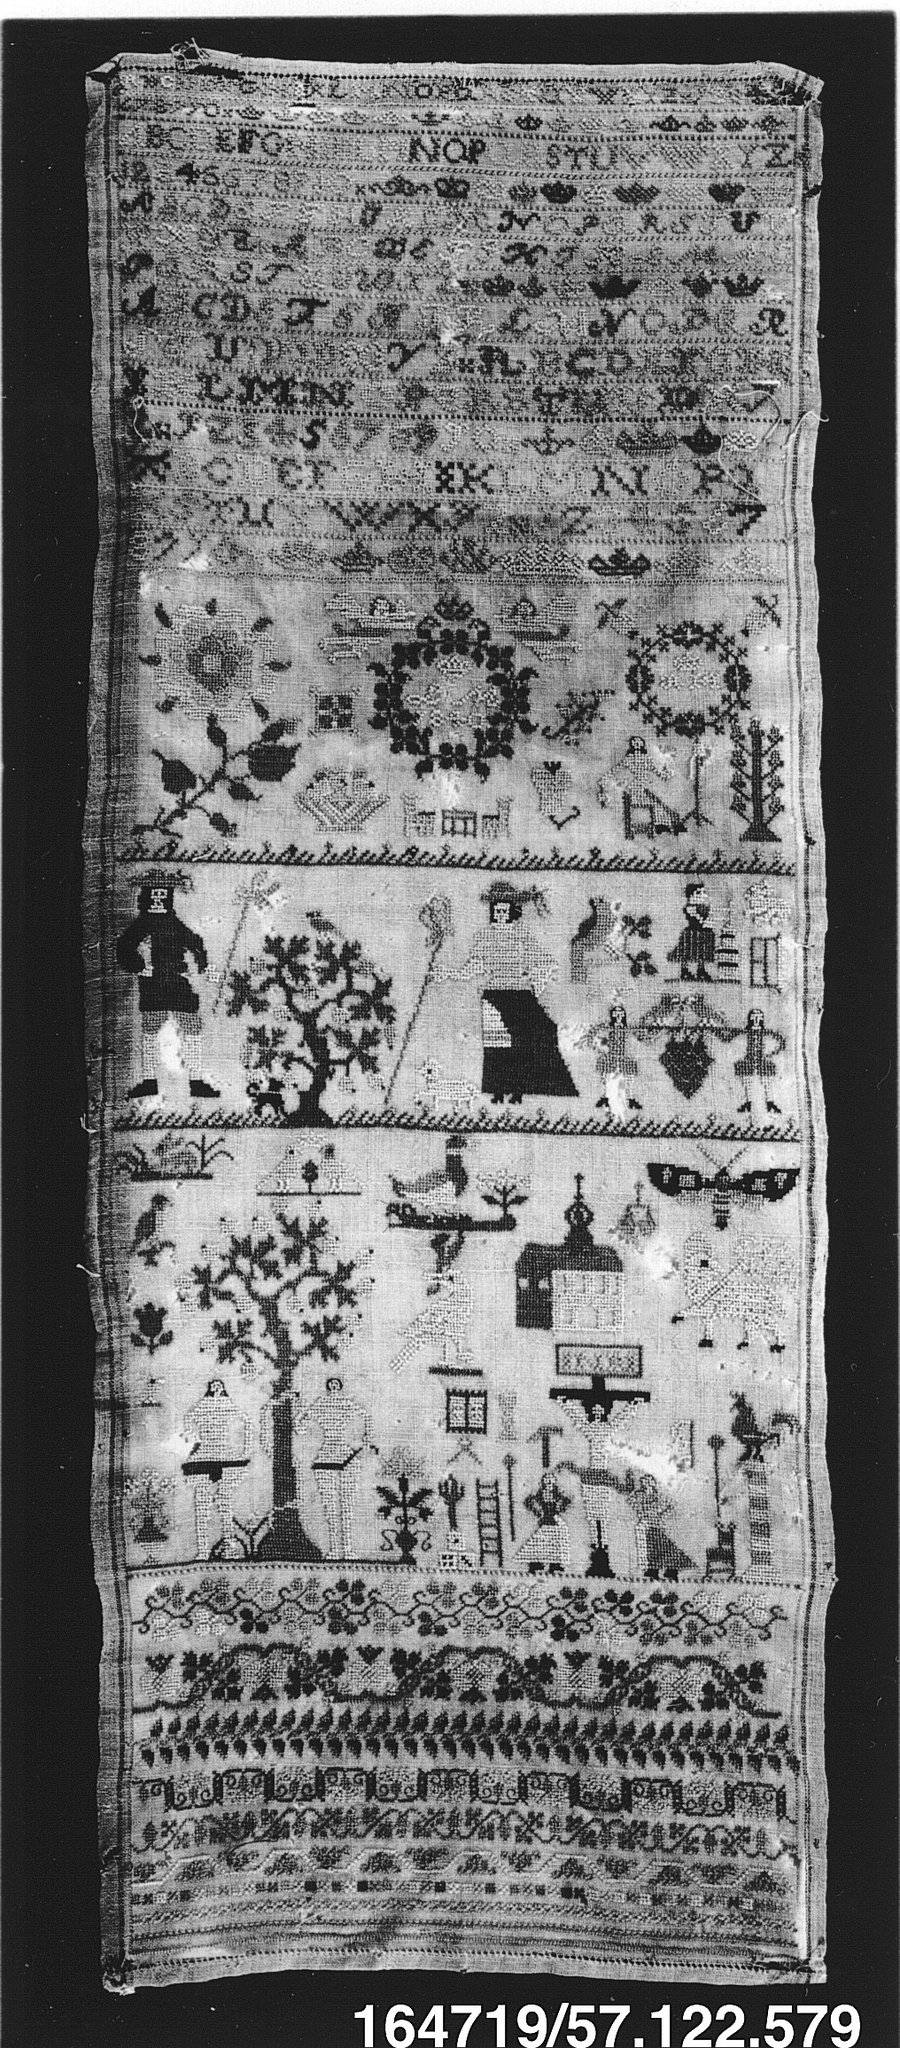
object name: sampler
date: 1840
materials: canvas, silk, wool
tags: wreaths,jesus